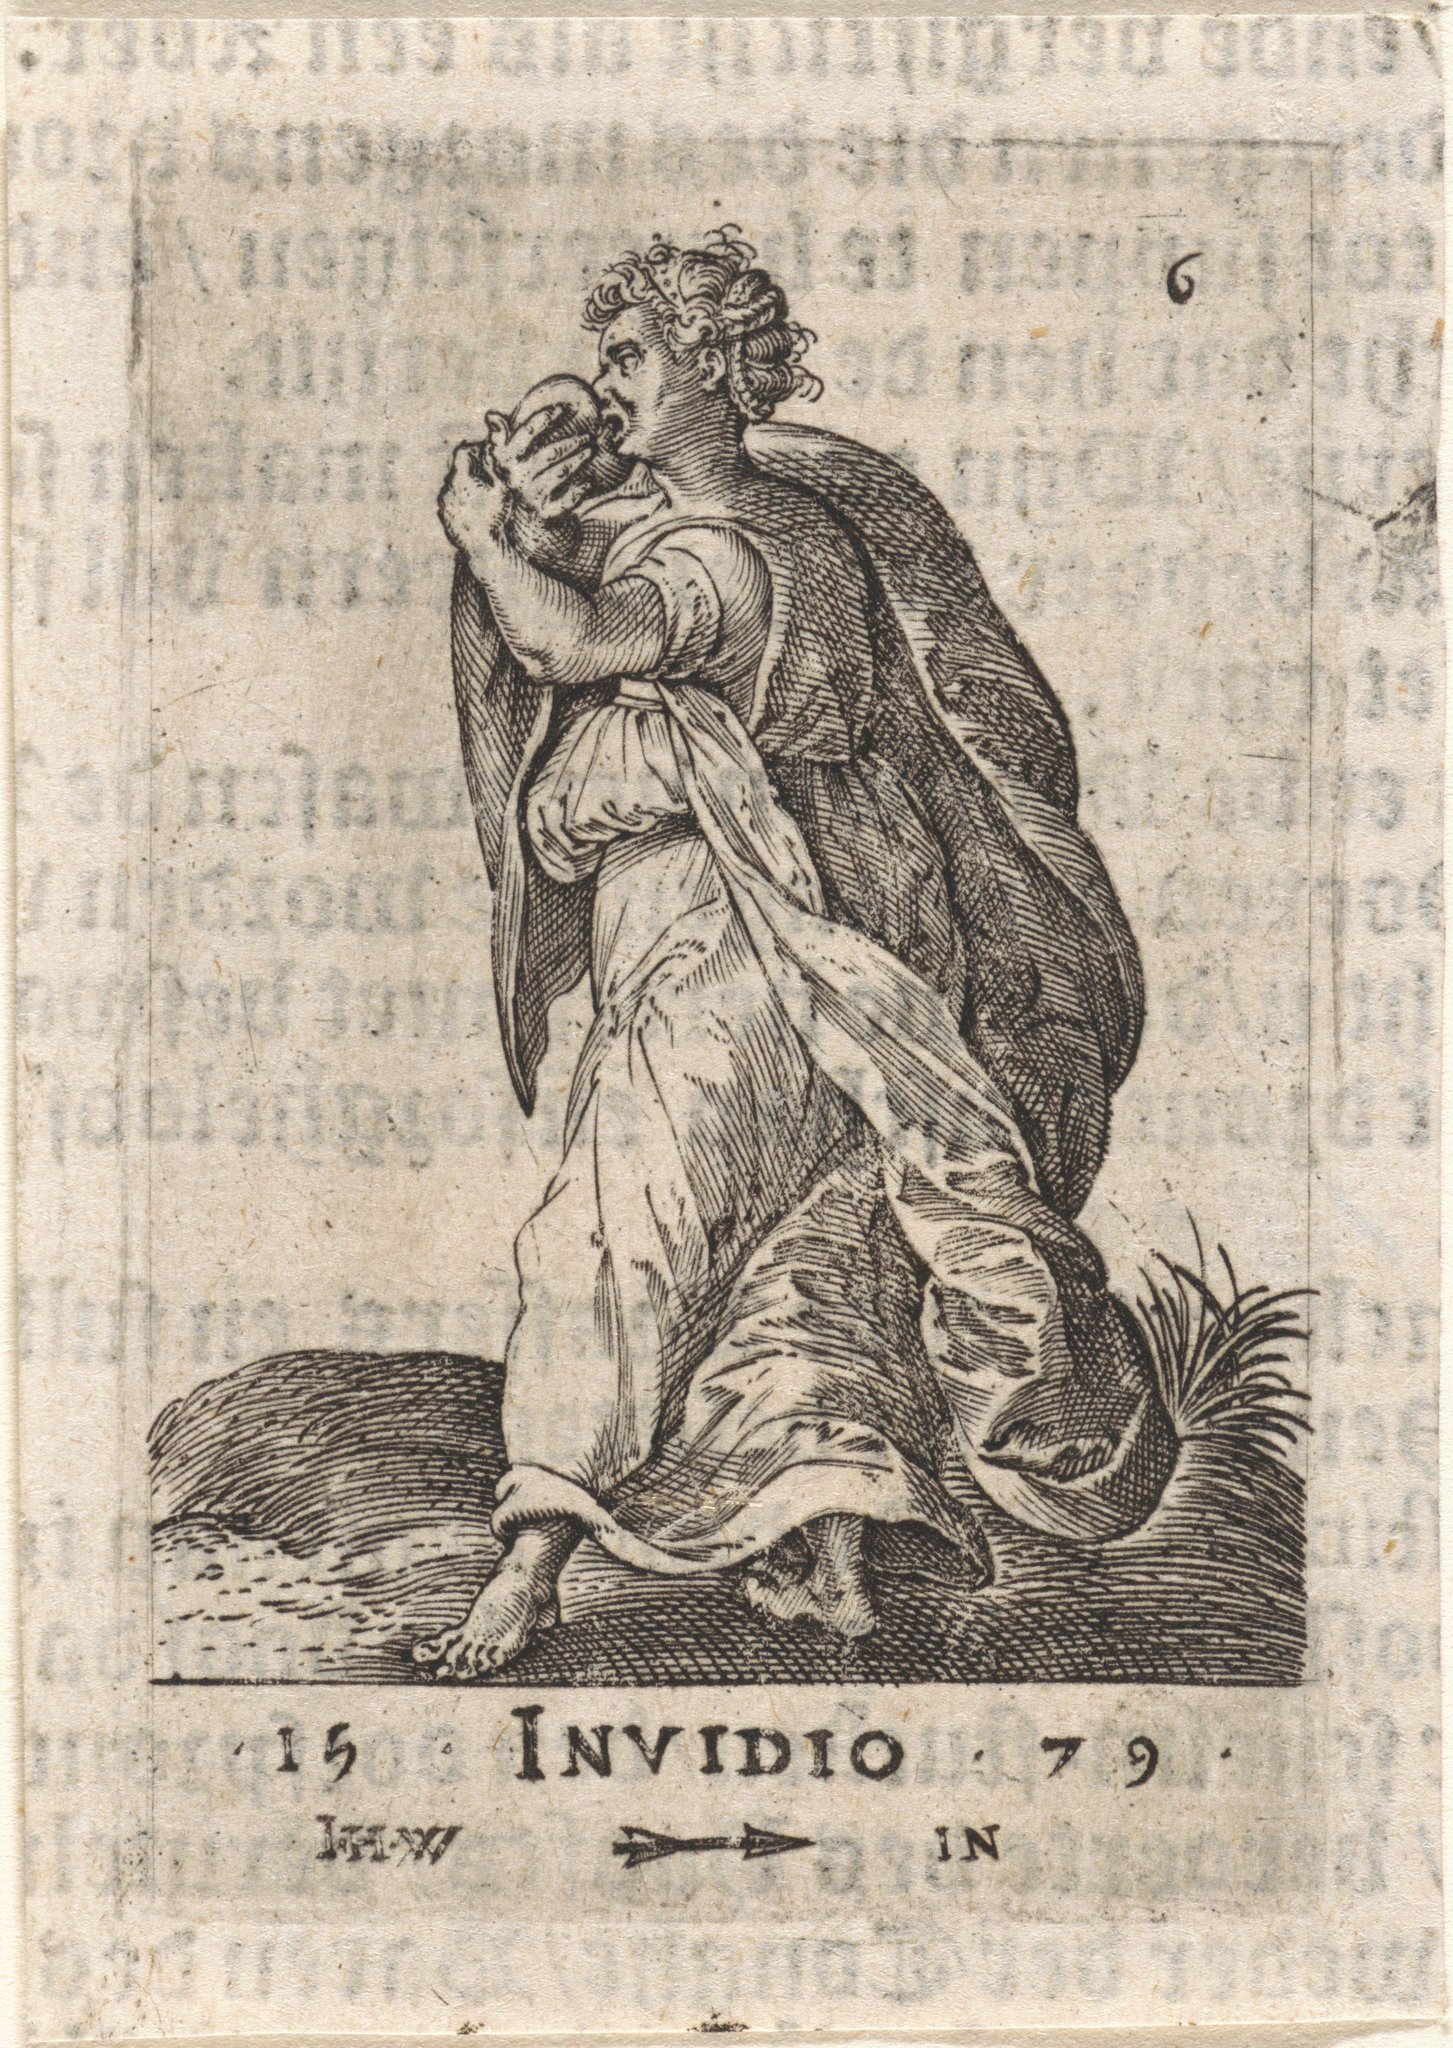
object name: print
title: Invidio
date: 1579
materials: paper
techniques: engraving, letterpress printing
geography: antwerp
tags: envy; 'invidia' (ripa) ~ personification of one of the seven deadly sins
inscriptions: date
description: Prent gebruikt als illustratie in: Const-toonneel, inhoudende de beschrijvinghe ende XL. Heerlijcke afbeeldindinghen: Onses Heeren Jesu Christi, met sijne apostelen, ende evangelisten, midtsgaders de hooft-deuchden ende ondeuchden. Ende ten laetsten de seven planeten. In coper gesneden door Johannis Wierix. De beschrijvinge is (...). Delft: Nicolaes de Clerck, 1609.